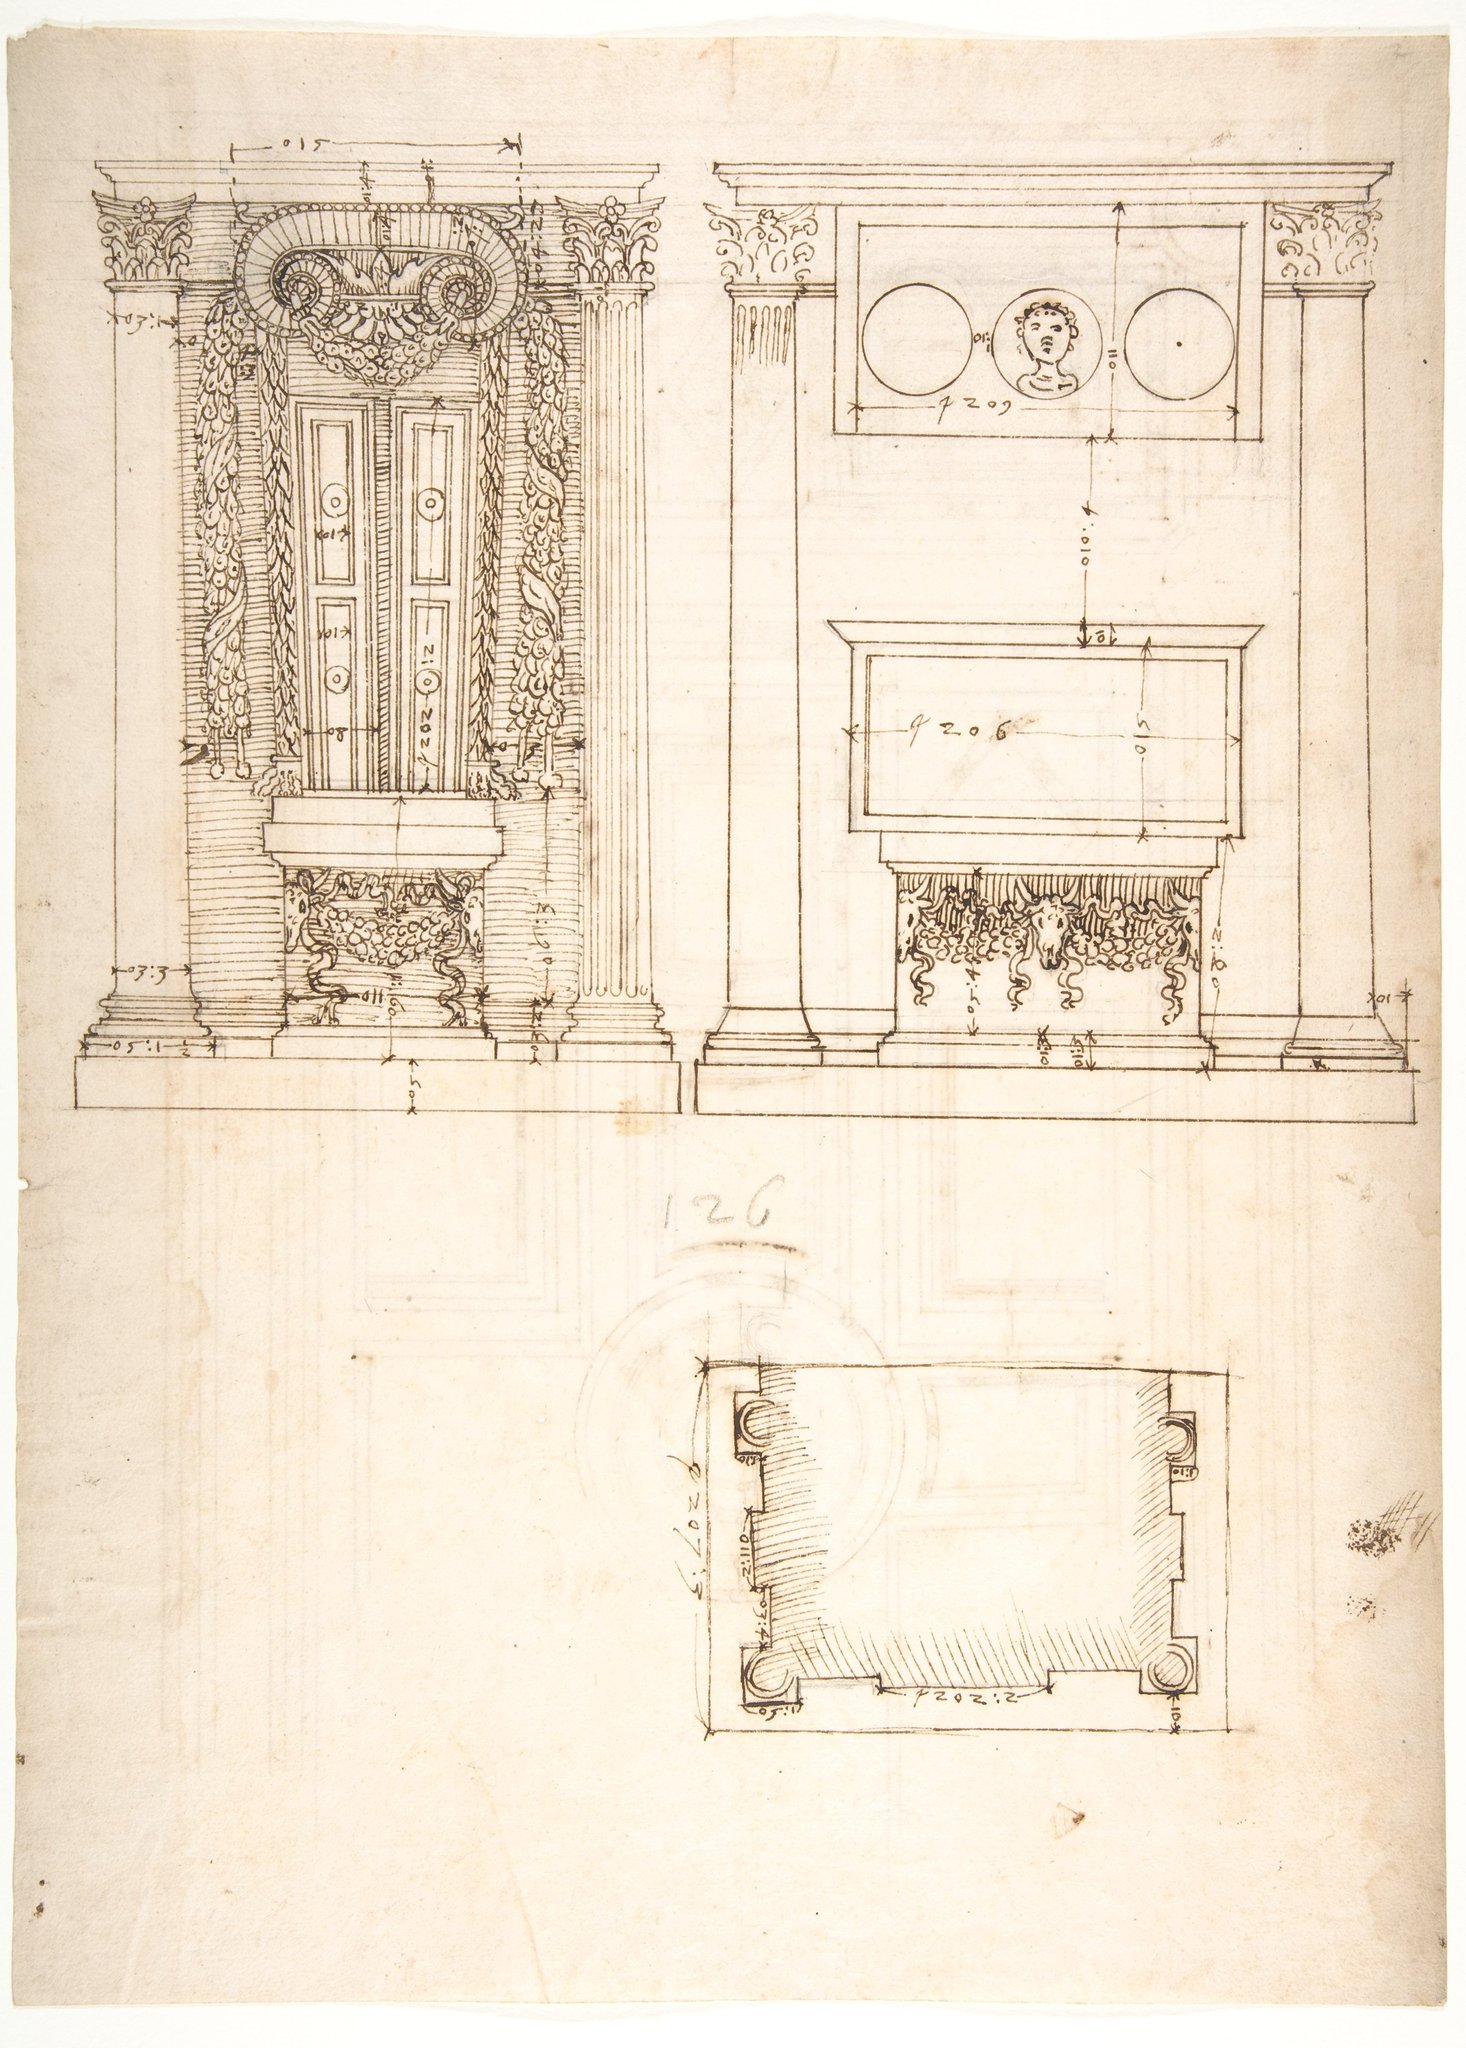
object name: collection ornament architecture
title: Unidentified, funerary altar, plan and elevations (recto) S. Giovanni Laterano, Oratorio della Santa Croce, paneling, elevation (verso)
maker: anonymous, french, 16th century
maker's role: draftsman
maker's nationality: french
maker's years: 1500-1600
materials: chalk, ink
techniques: incising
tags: altars